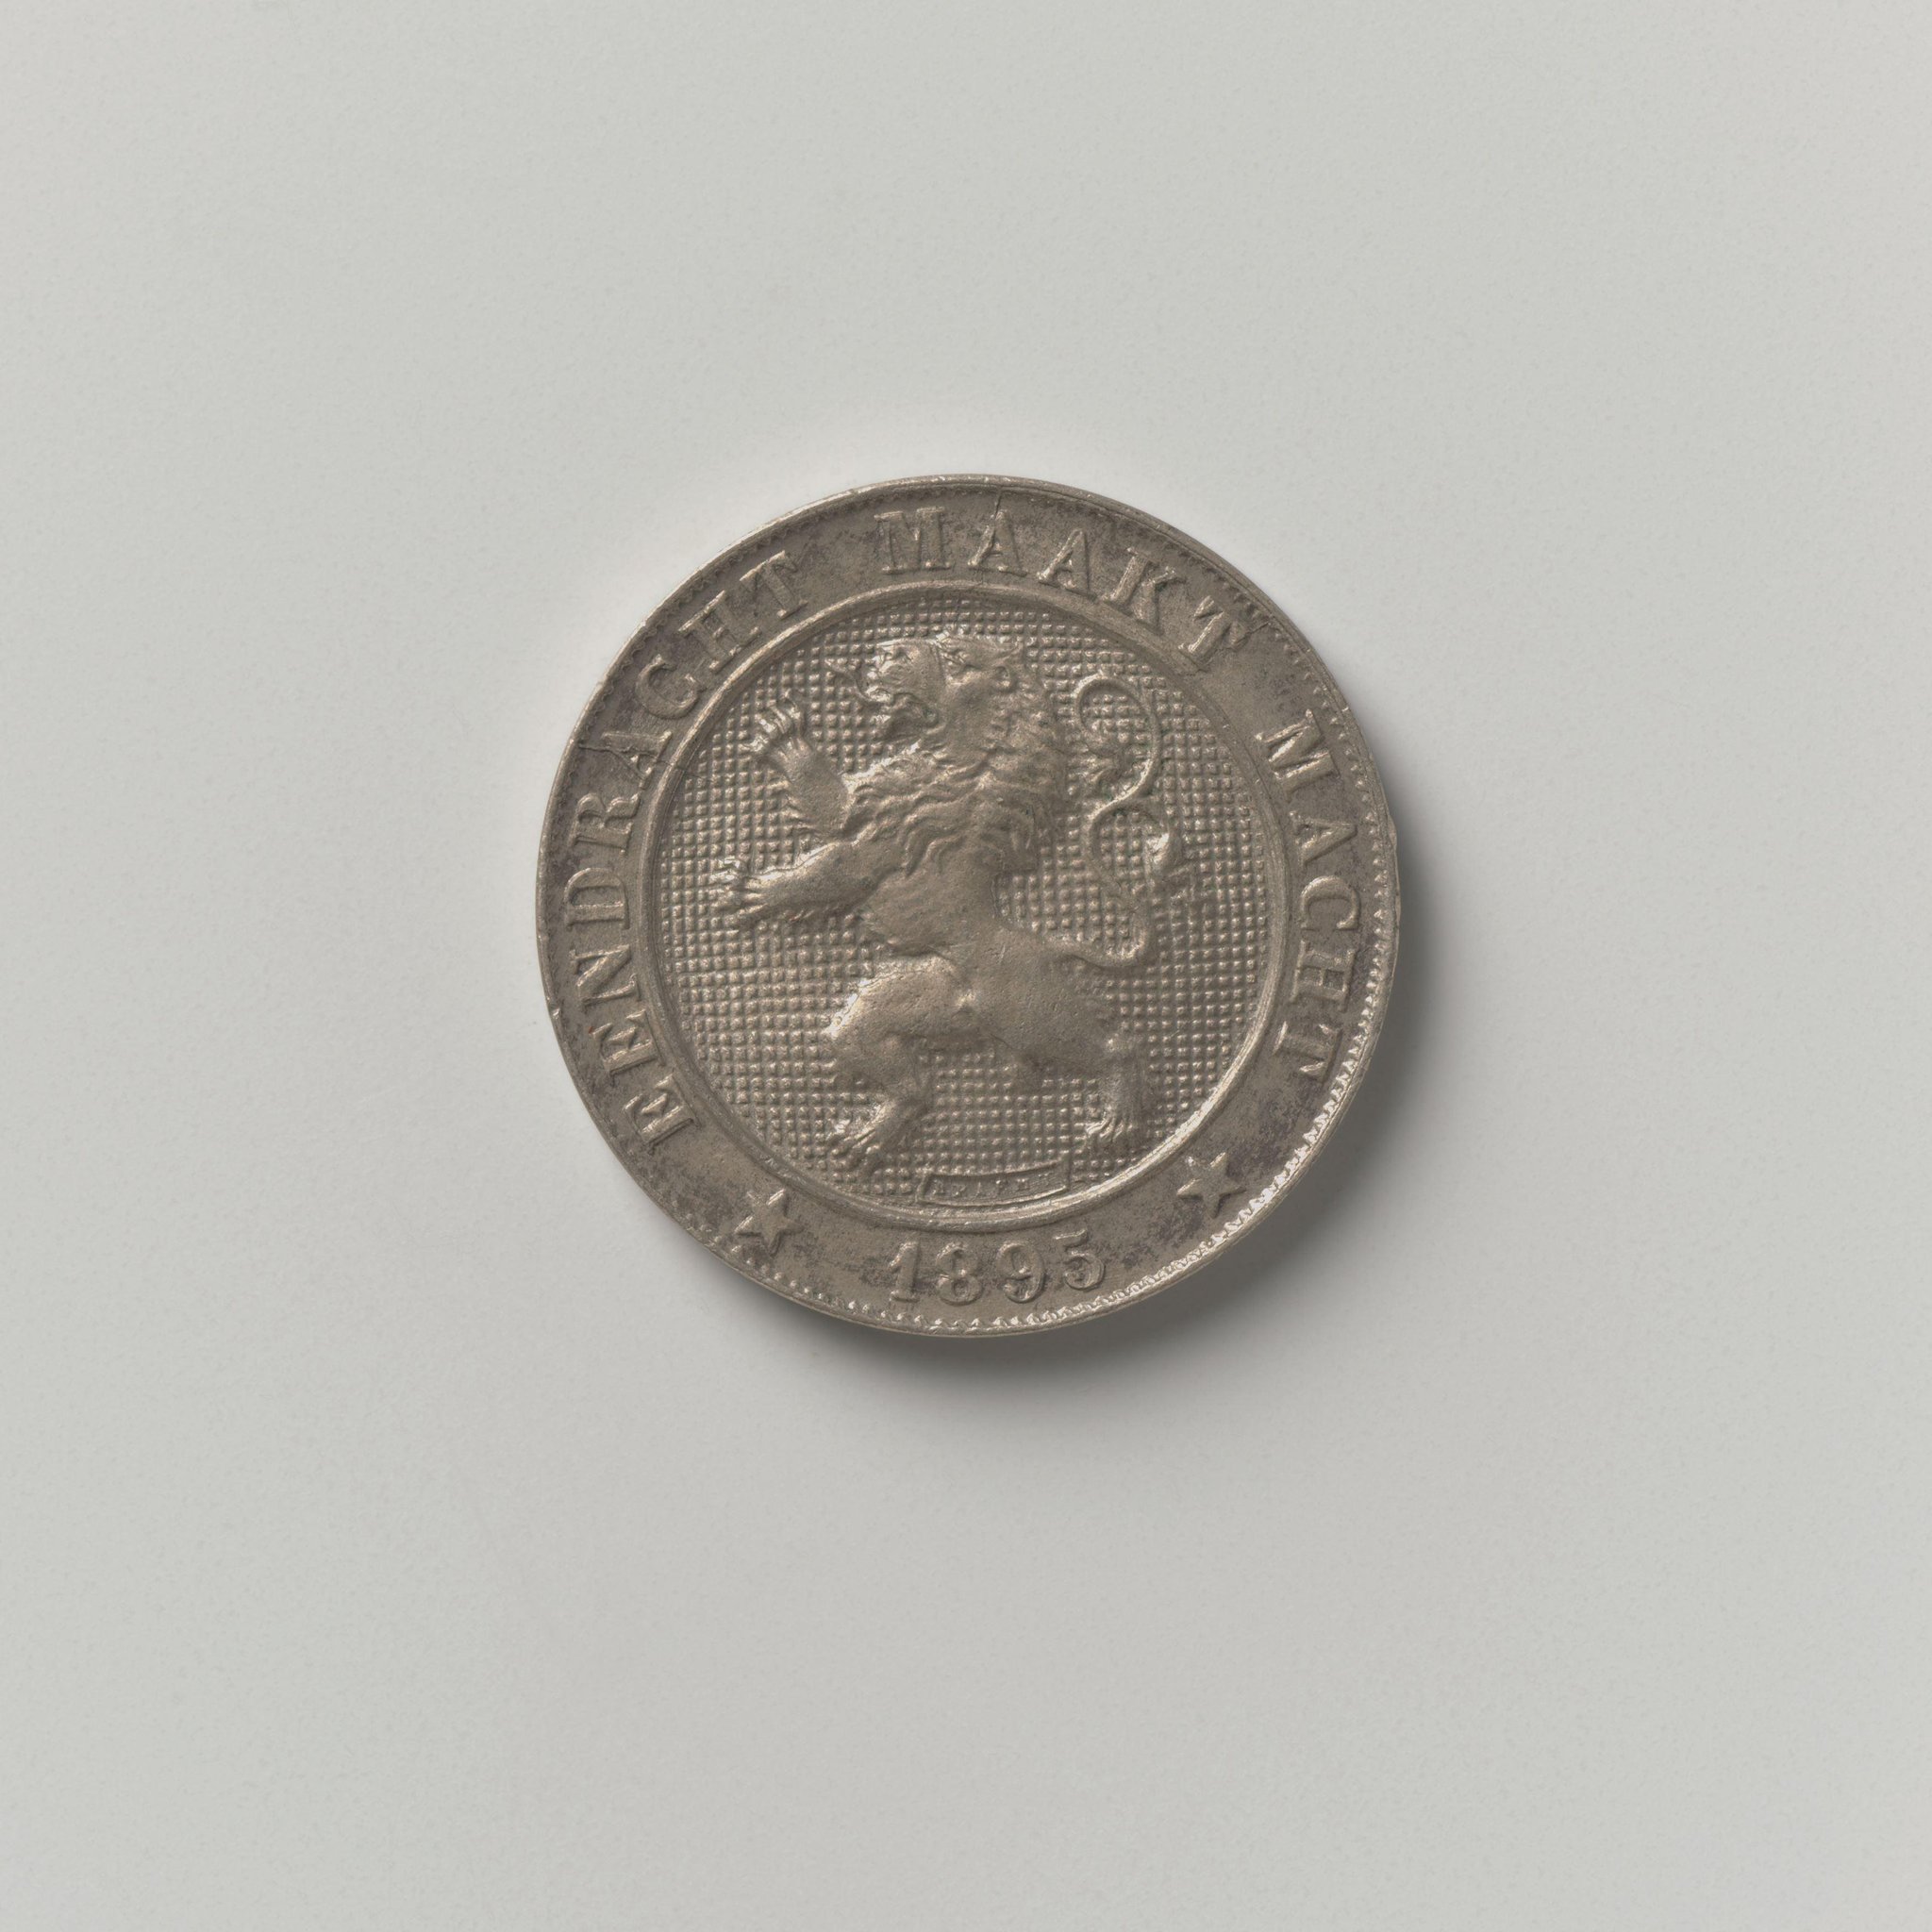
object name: coin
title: 5 centiemen uit België van Leopold II, 1895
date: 1895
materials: nickel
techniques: striking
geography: brussels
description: Nikkelen munt. Voorzijde: in gearceerd veld waarde-aanduiding 5 centiemen in twee regels, waaronder ster. Keerzijde: In gearceerd veld staande leeuw naar links. Jaartal onderaan. Inliggende kartelrand.